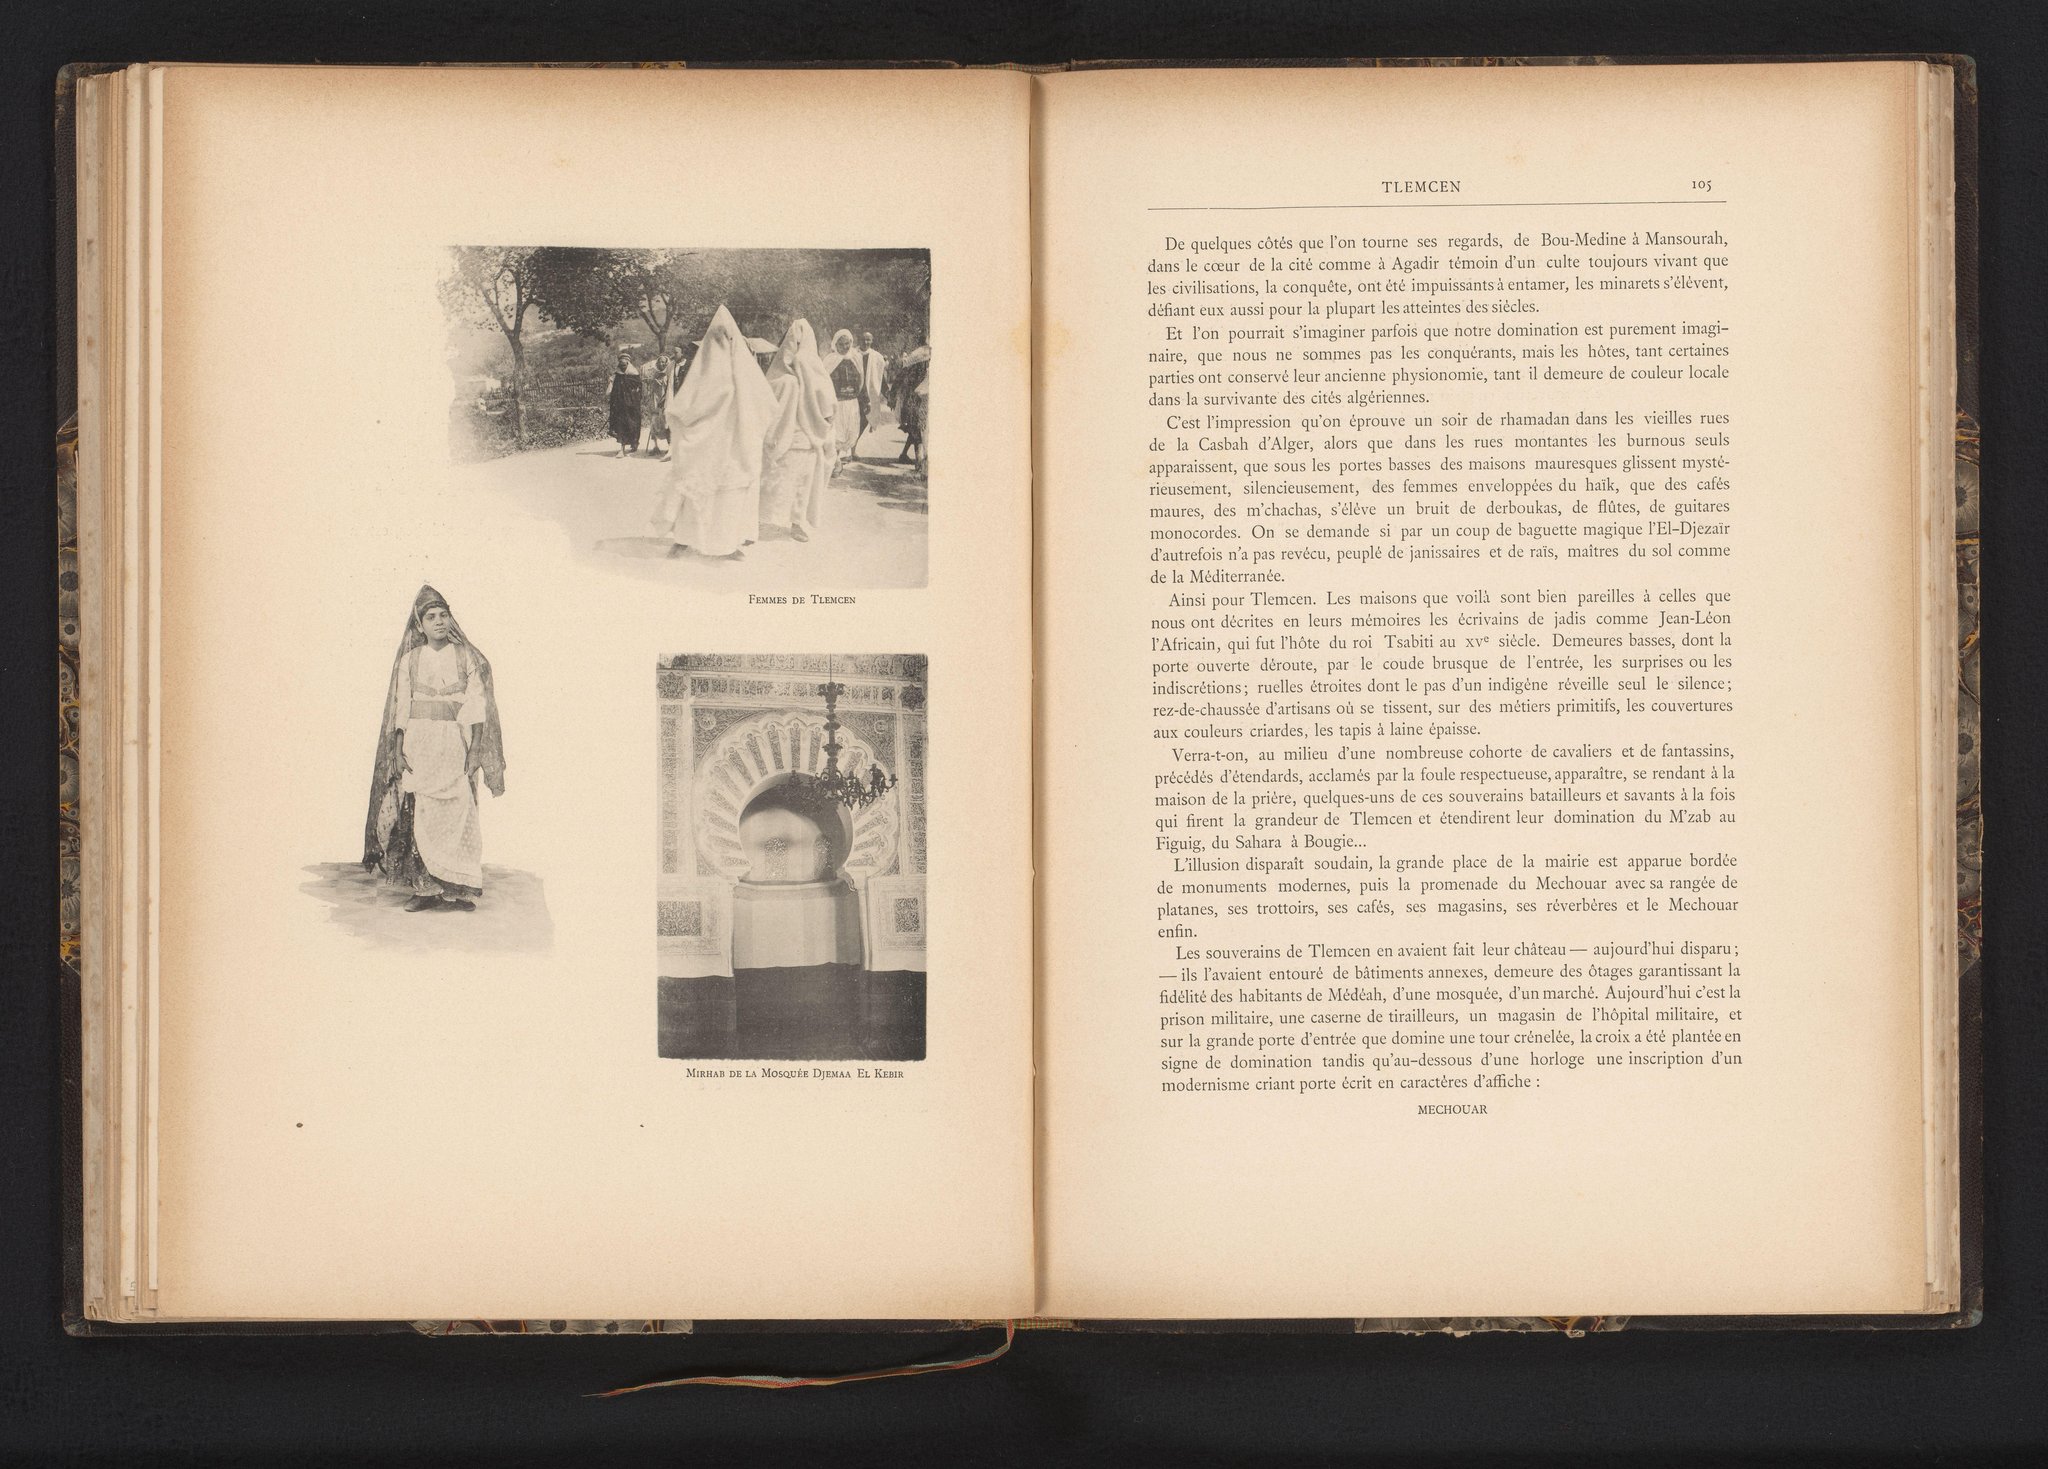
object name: photomechanical print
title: Vrouwen op straat in Tlemcen, Algerije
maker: jules gervais-courtellemont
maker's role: fotograaf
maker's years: 1863-1931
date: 1888-1893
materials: paper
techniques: photograph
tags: adult woman, street